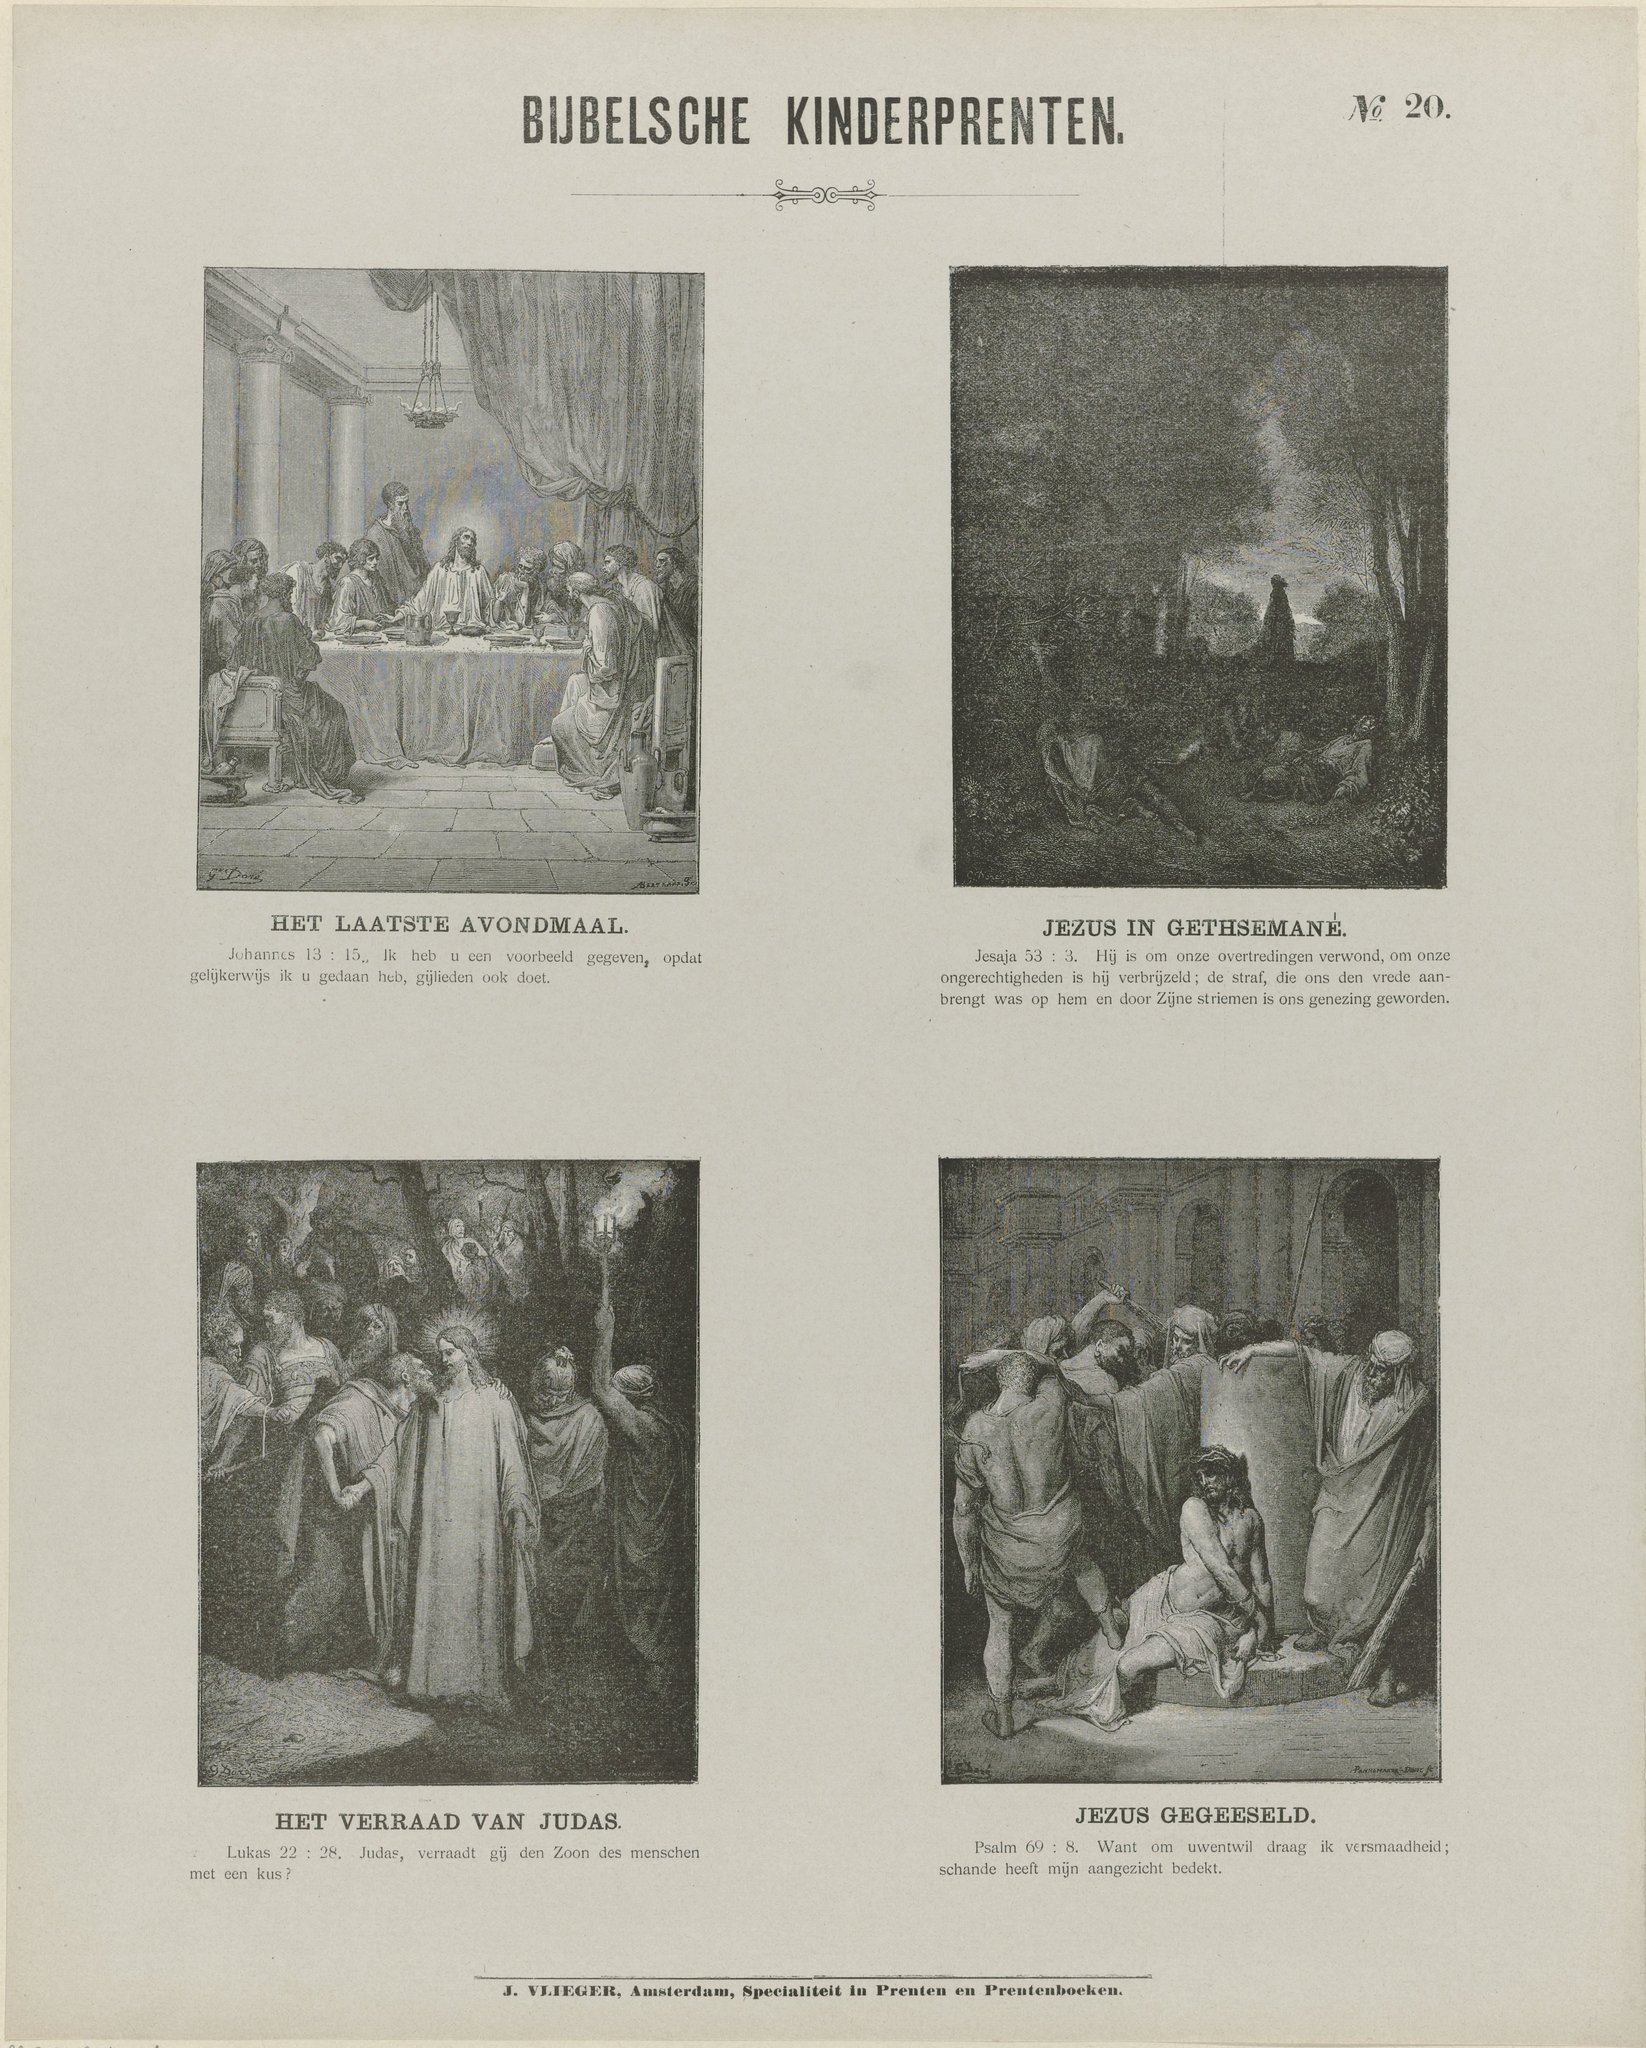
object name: popular print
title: Bijbelsche kinderprenten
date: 1869-1908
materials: paper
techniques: letterpress printing, photoaquatint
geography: amsterdam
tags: the episode of the last supper, the kiss of judas: accompanied by soldiers with torches and lanterns, he kisses christ, the sleeping apostles (alone) ~ garden of gethsemane, christ on the whipping-post (after the flagellation), new testament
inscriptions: collector's mark: Lugt 2760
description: Blad met 4 voorstellingen van verhalen uit het Nieuwe Testament: het Laatste Avondmaal, de slapende apostelen in Getsemane, het verraad van Judas en Christus vlak na de geseling. Onder elke afbeelding een Bijbeltekst. Genummerd rechtsboven: No. 20.